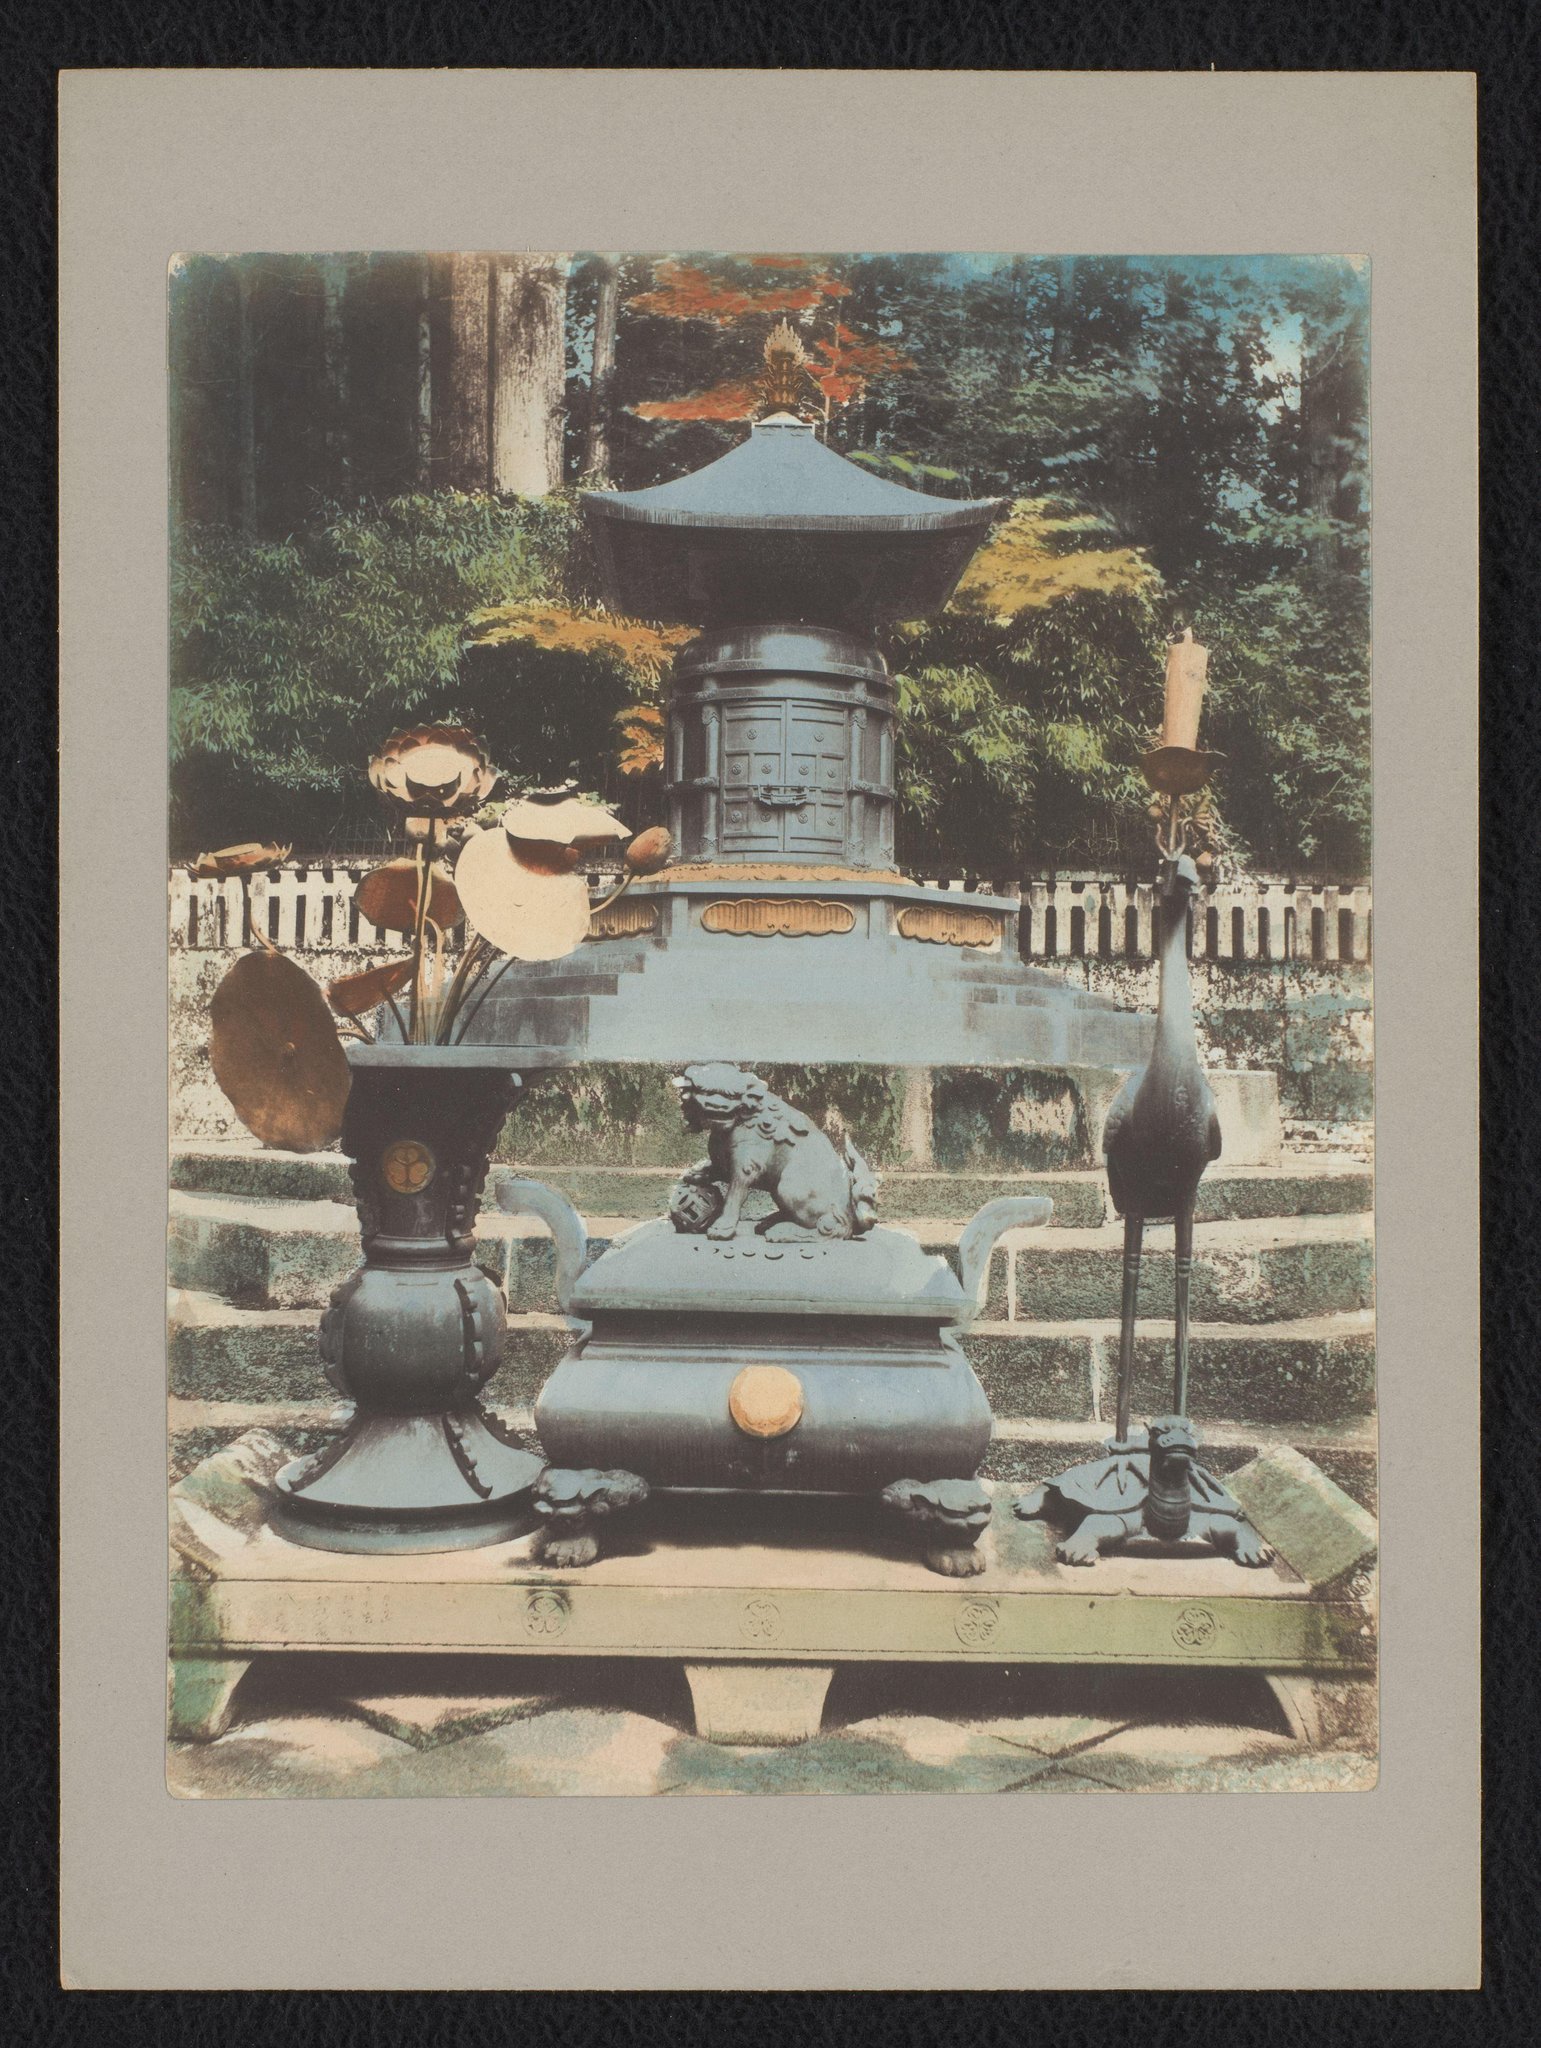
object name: photograph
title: Graftombe van Ieyasu, Nikko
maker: Anonymous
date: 1895-1915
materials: cardboard, photographic support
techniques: salted paper print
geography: nikko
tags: nikko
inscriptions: annotation: ‘38. Tomb.’